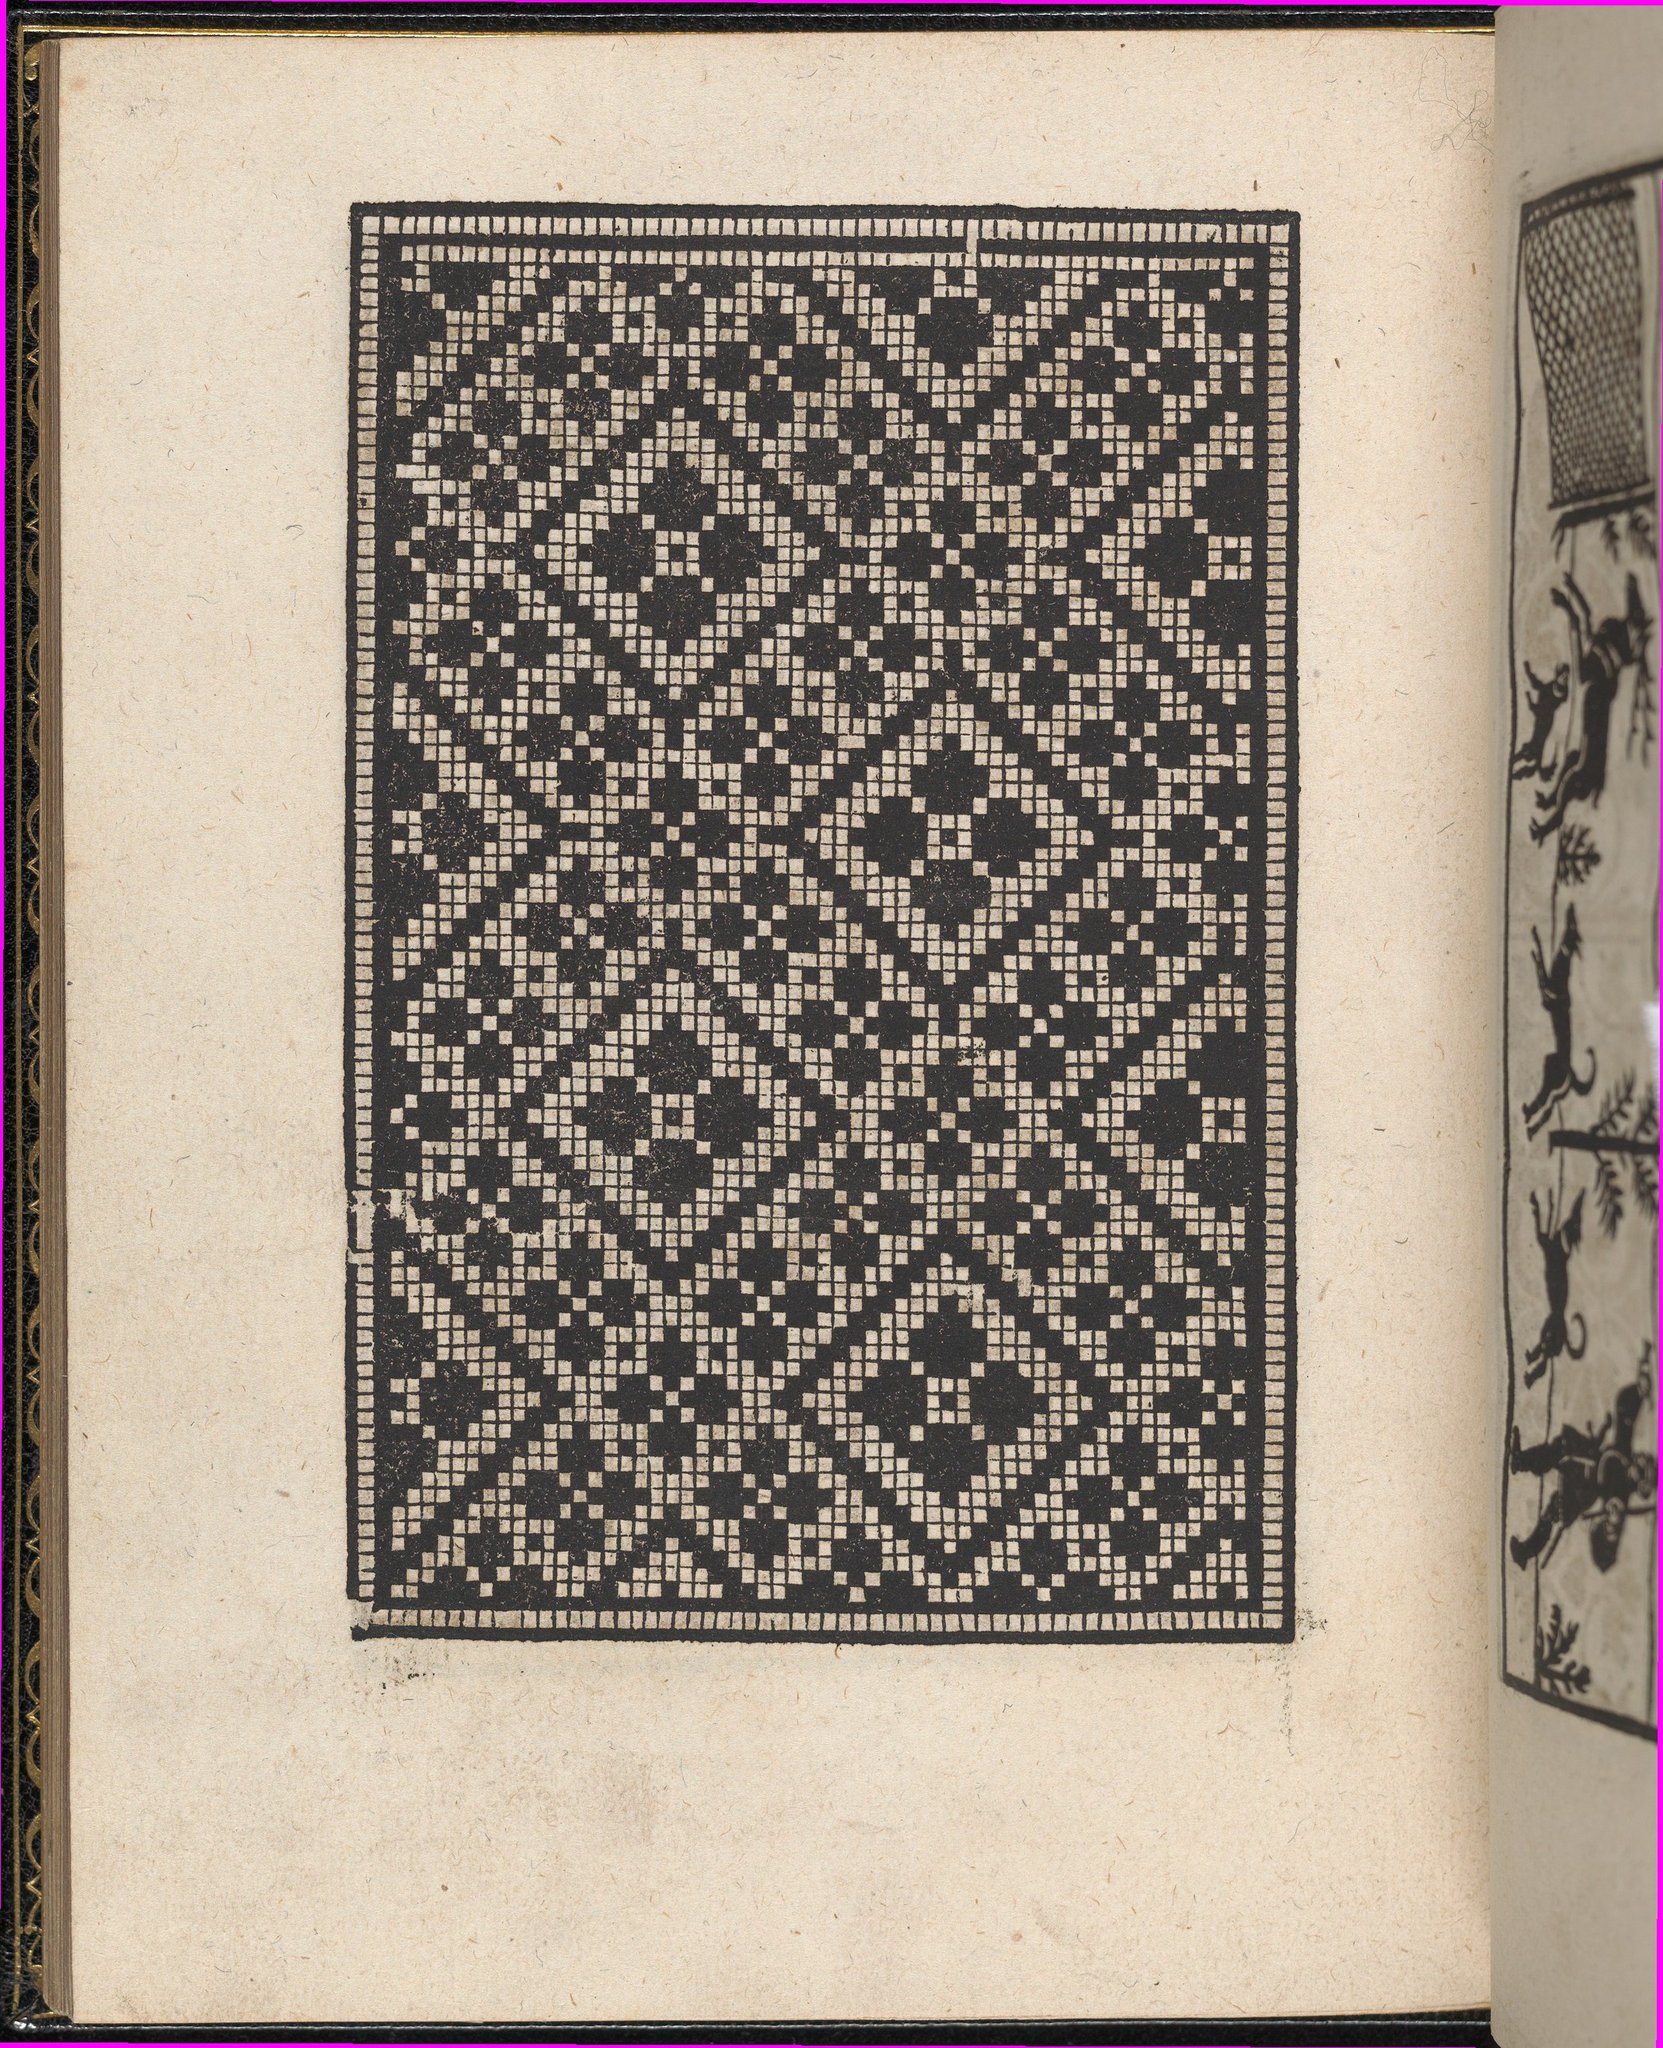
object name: book print ornament architecture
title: Page from Ein new kunstlich Modelbuch...(Page 42v)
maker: peter quentel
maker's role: publisher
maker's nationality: german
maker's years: 1500-1550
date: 1544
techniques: woodcut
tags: ornament